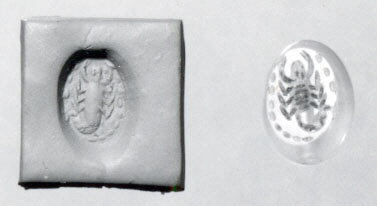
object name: stamp seal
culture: sasanian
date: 201-700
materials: quartz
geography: iran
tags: scorpions